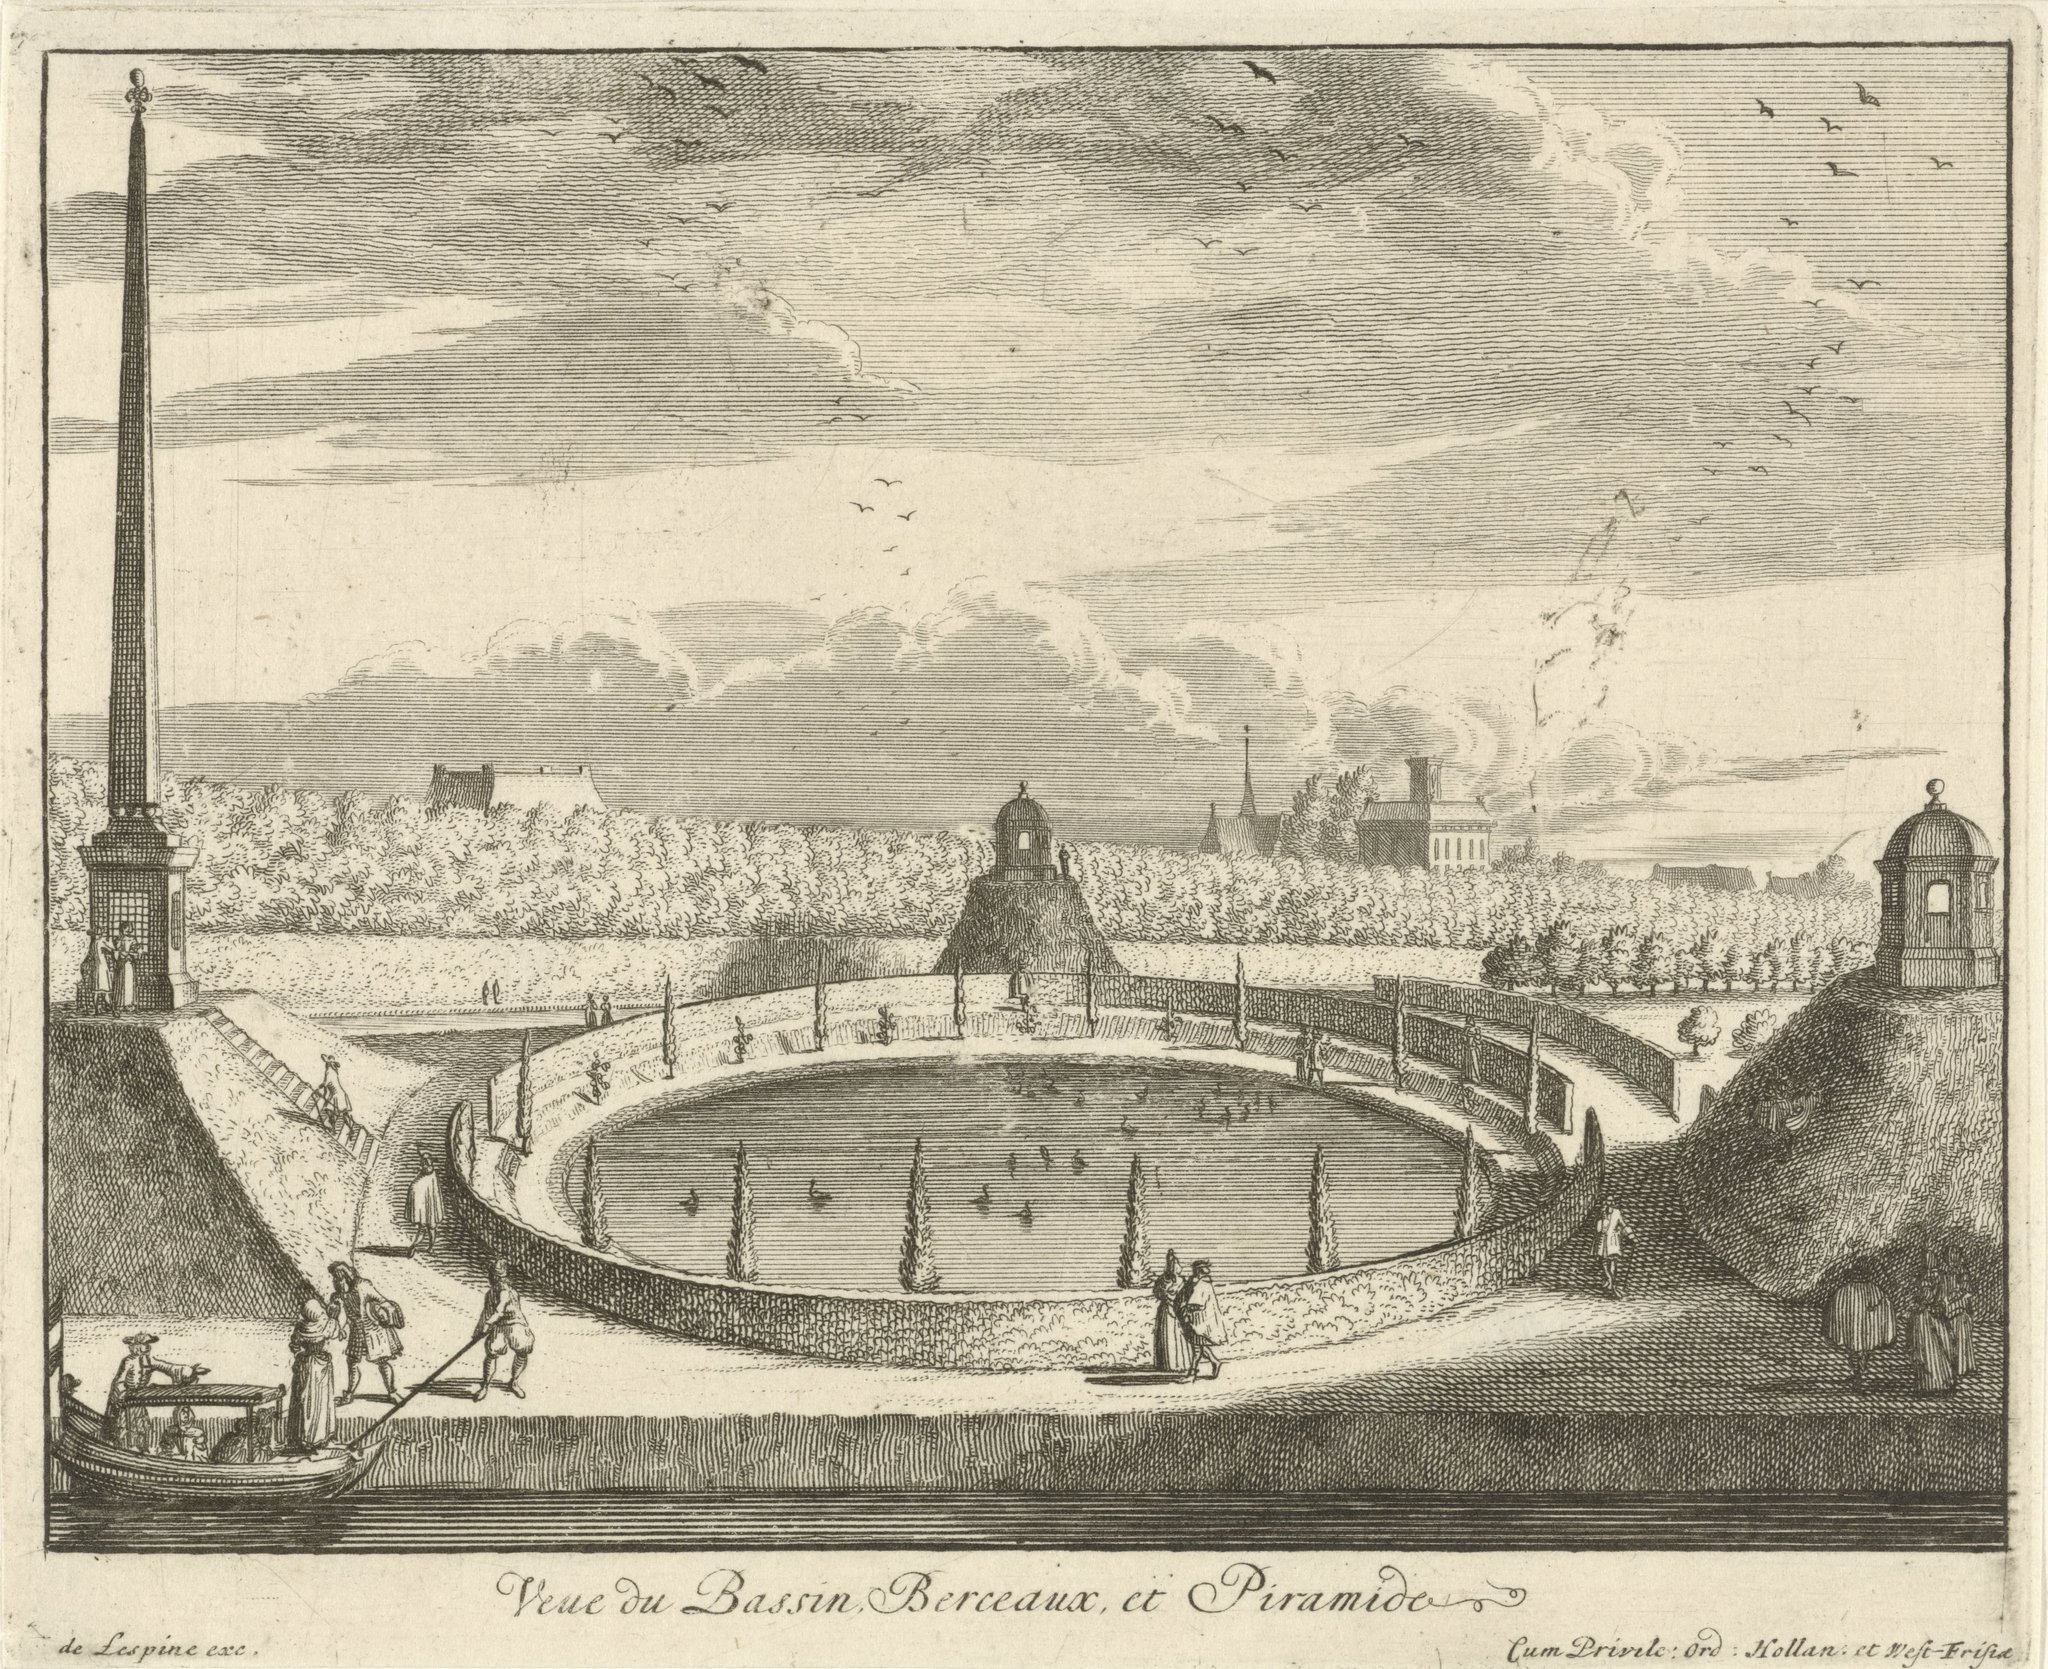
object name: print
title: Vijver en obelisk in de tuin van Kasteel Gunterstein, Breukelen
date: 1680-1696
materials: paper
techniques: engraving, etching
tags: magdalena poulle, obelisks (garden ornaments), garden pond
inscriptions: collector's mark: Lugt 2228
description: De vijver en de obelisk in de tuin van Kasteel Gunterstein te Breukelen. Op de voorgrond figuren in en bij een trekschuit.